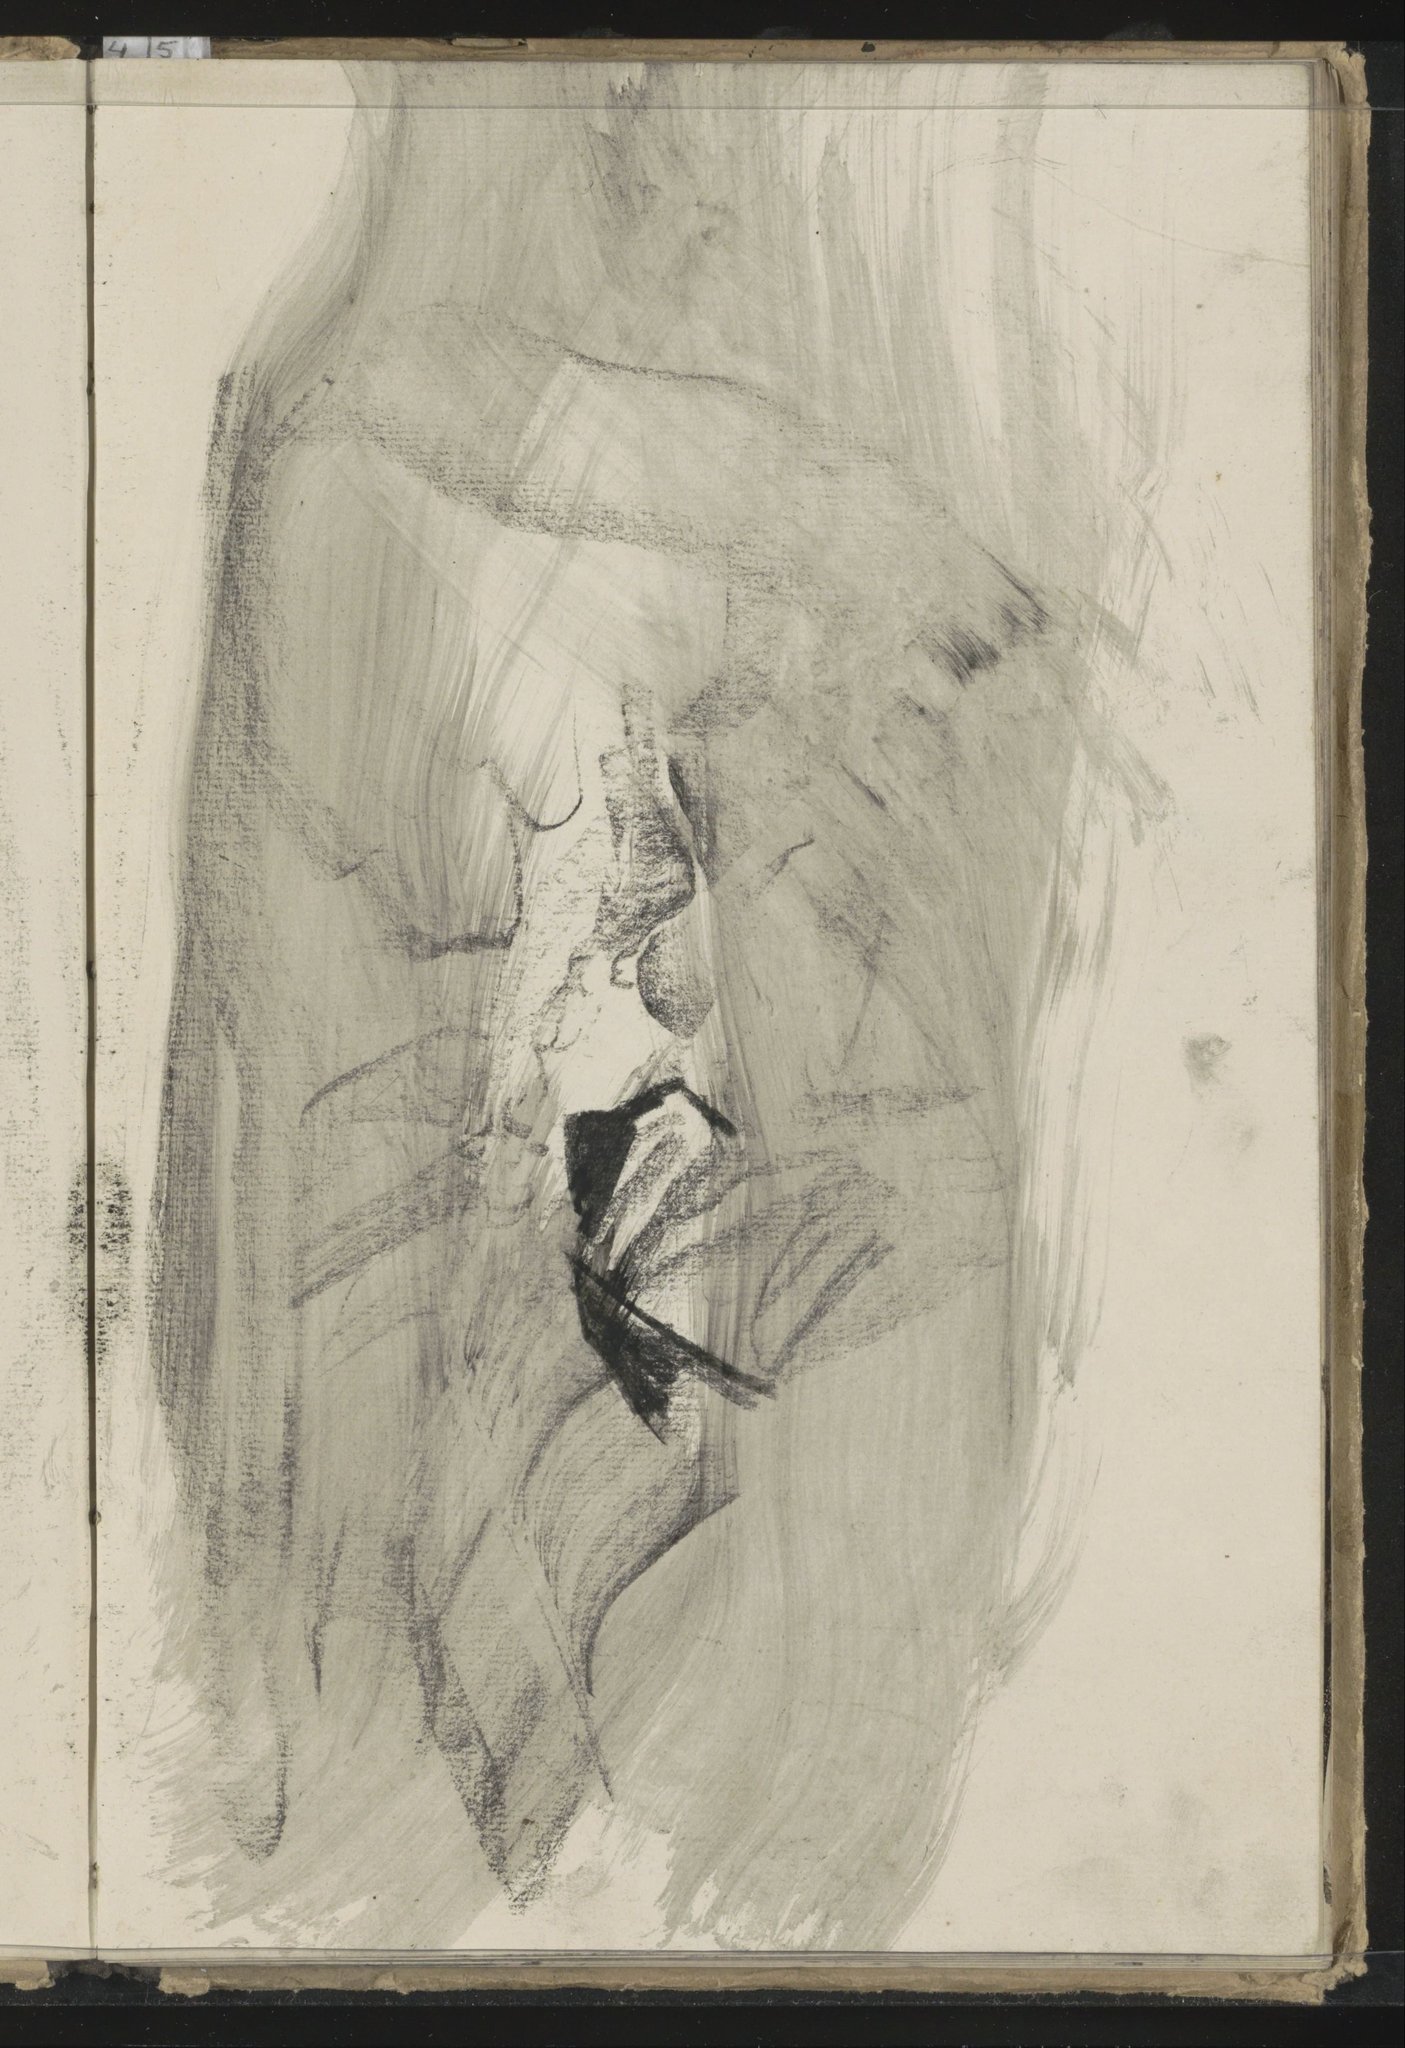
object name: sketchbook leaf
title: Studie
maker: carel adolph lion cachet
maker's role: draughtsman, print maker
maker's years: 1864-1945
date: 1890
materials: chalk, paper, watercolor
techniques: brush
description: Blad 3 recto uit een schetsboek met 38 bladen.